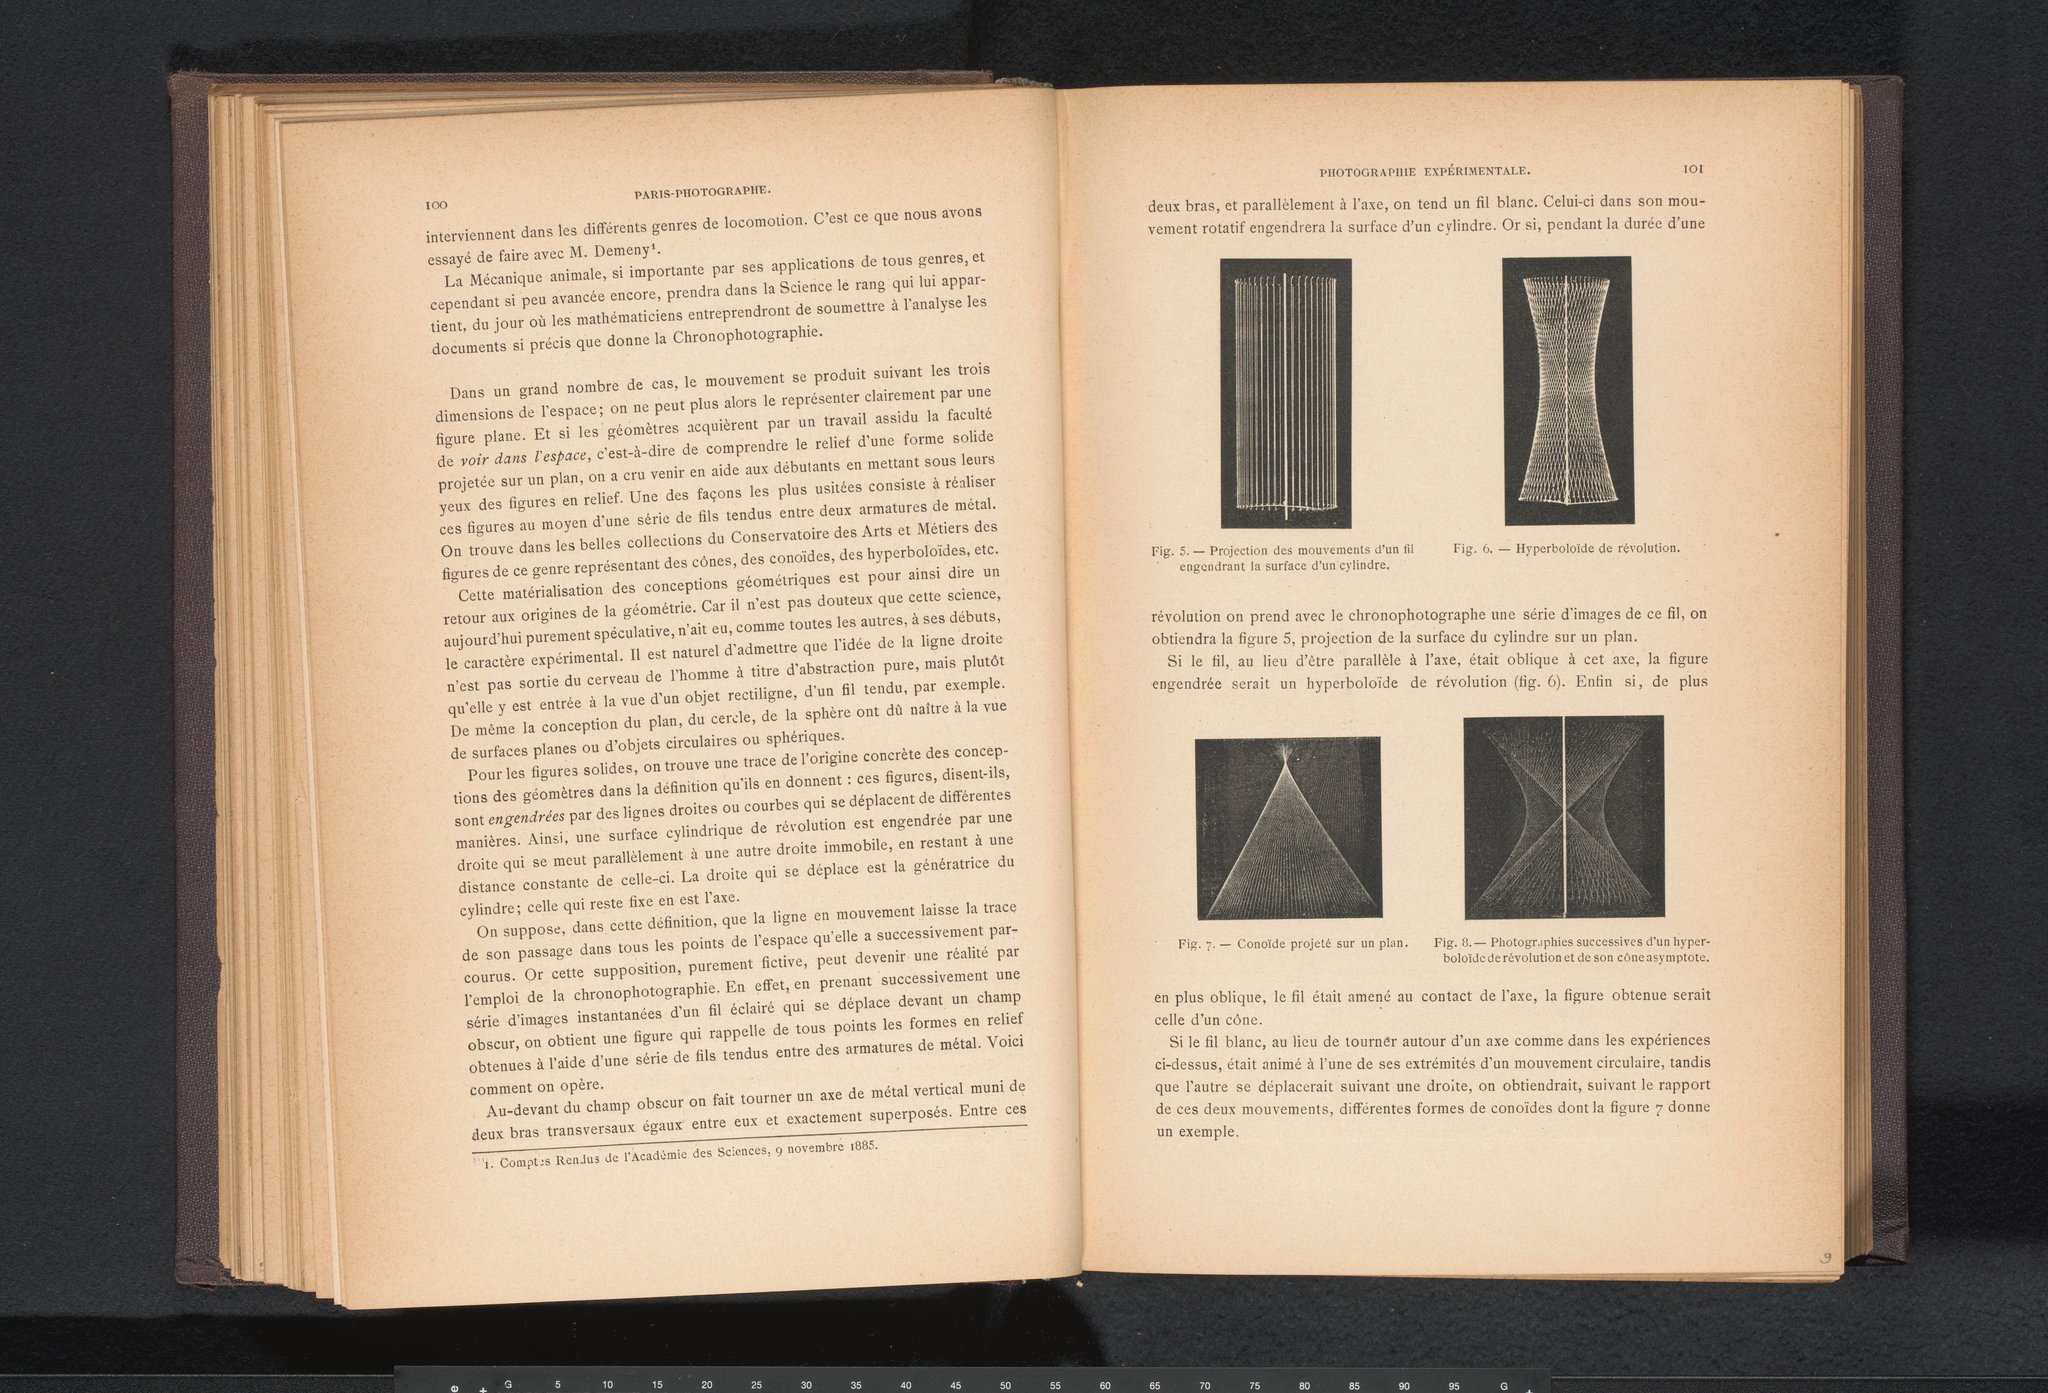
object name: page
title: Vier figuren ter verduidelijking van chronofotografie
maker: Anonymous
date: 1883-1893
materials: paper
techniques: autotype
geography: france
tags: first beginnings of photography and cinematography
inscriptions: number: ‘Fig. 5. Fig. 6. Fig. 7. Fig. 8.’, inscription: ‘Projection des mouvements d'un fil engendrant la surface d'un cylindre. Hyperboloïde de révolution. Conoïde projeté sur un plan. Photographies successives d'un hyperboloïde de rèvolution et de son cône asymptote.’